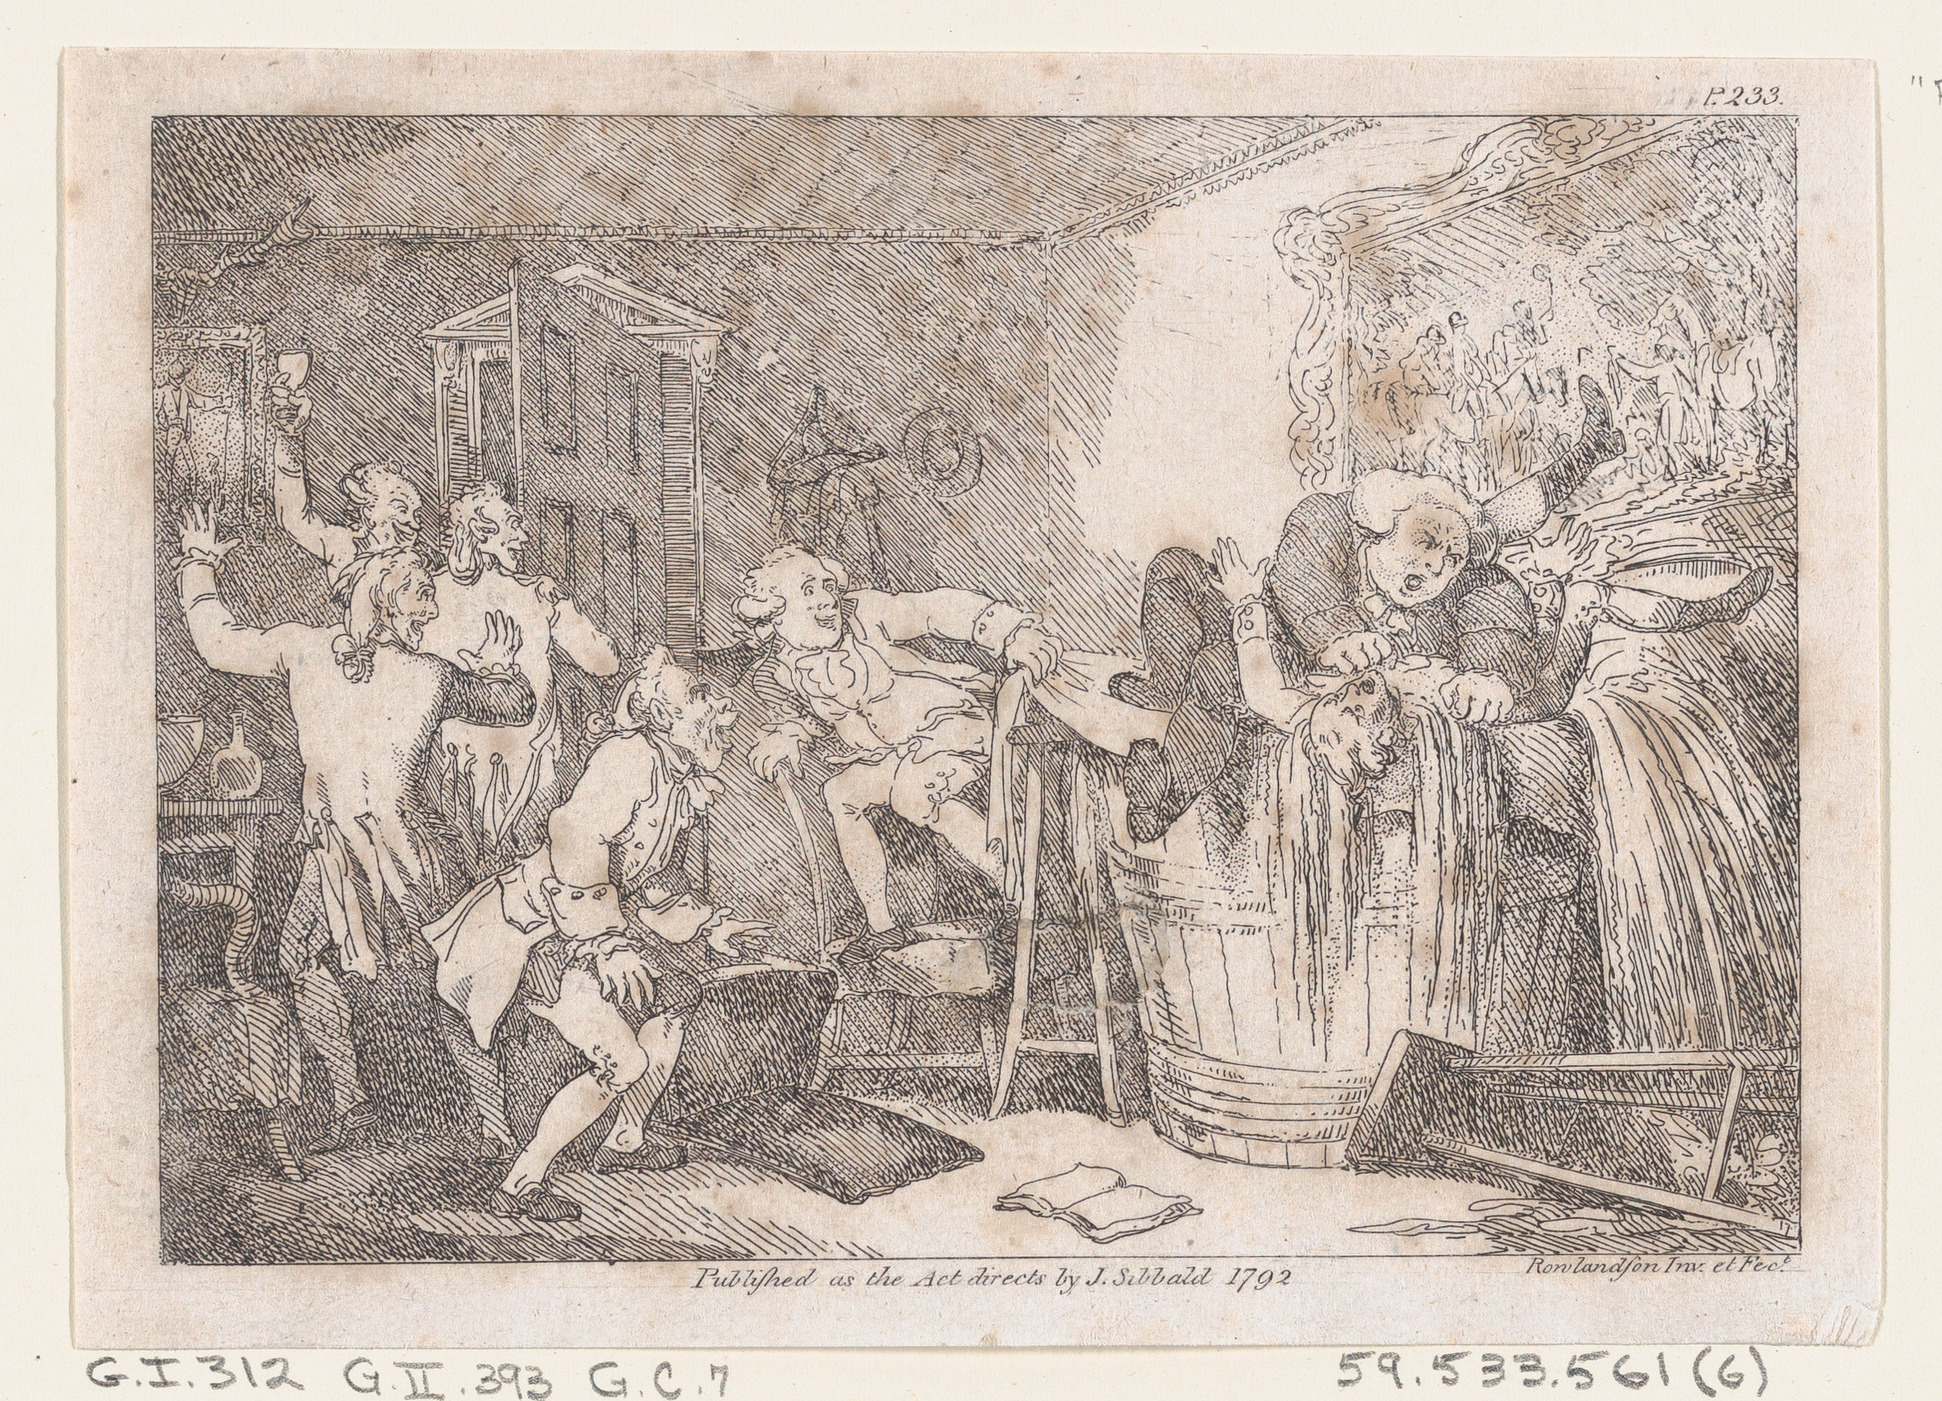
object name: print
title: Parson Adams Betrayed into an Unhappy Dunking Scene, from "The Adventures of Joseph Andrews, and his friend Mr. Abraham Adams"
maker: thomas rowlandson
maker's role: artist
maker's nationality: british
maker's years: 1757-1827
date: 1792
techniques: etching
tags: satire,men